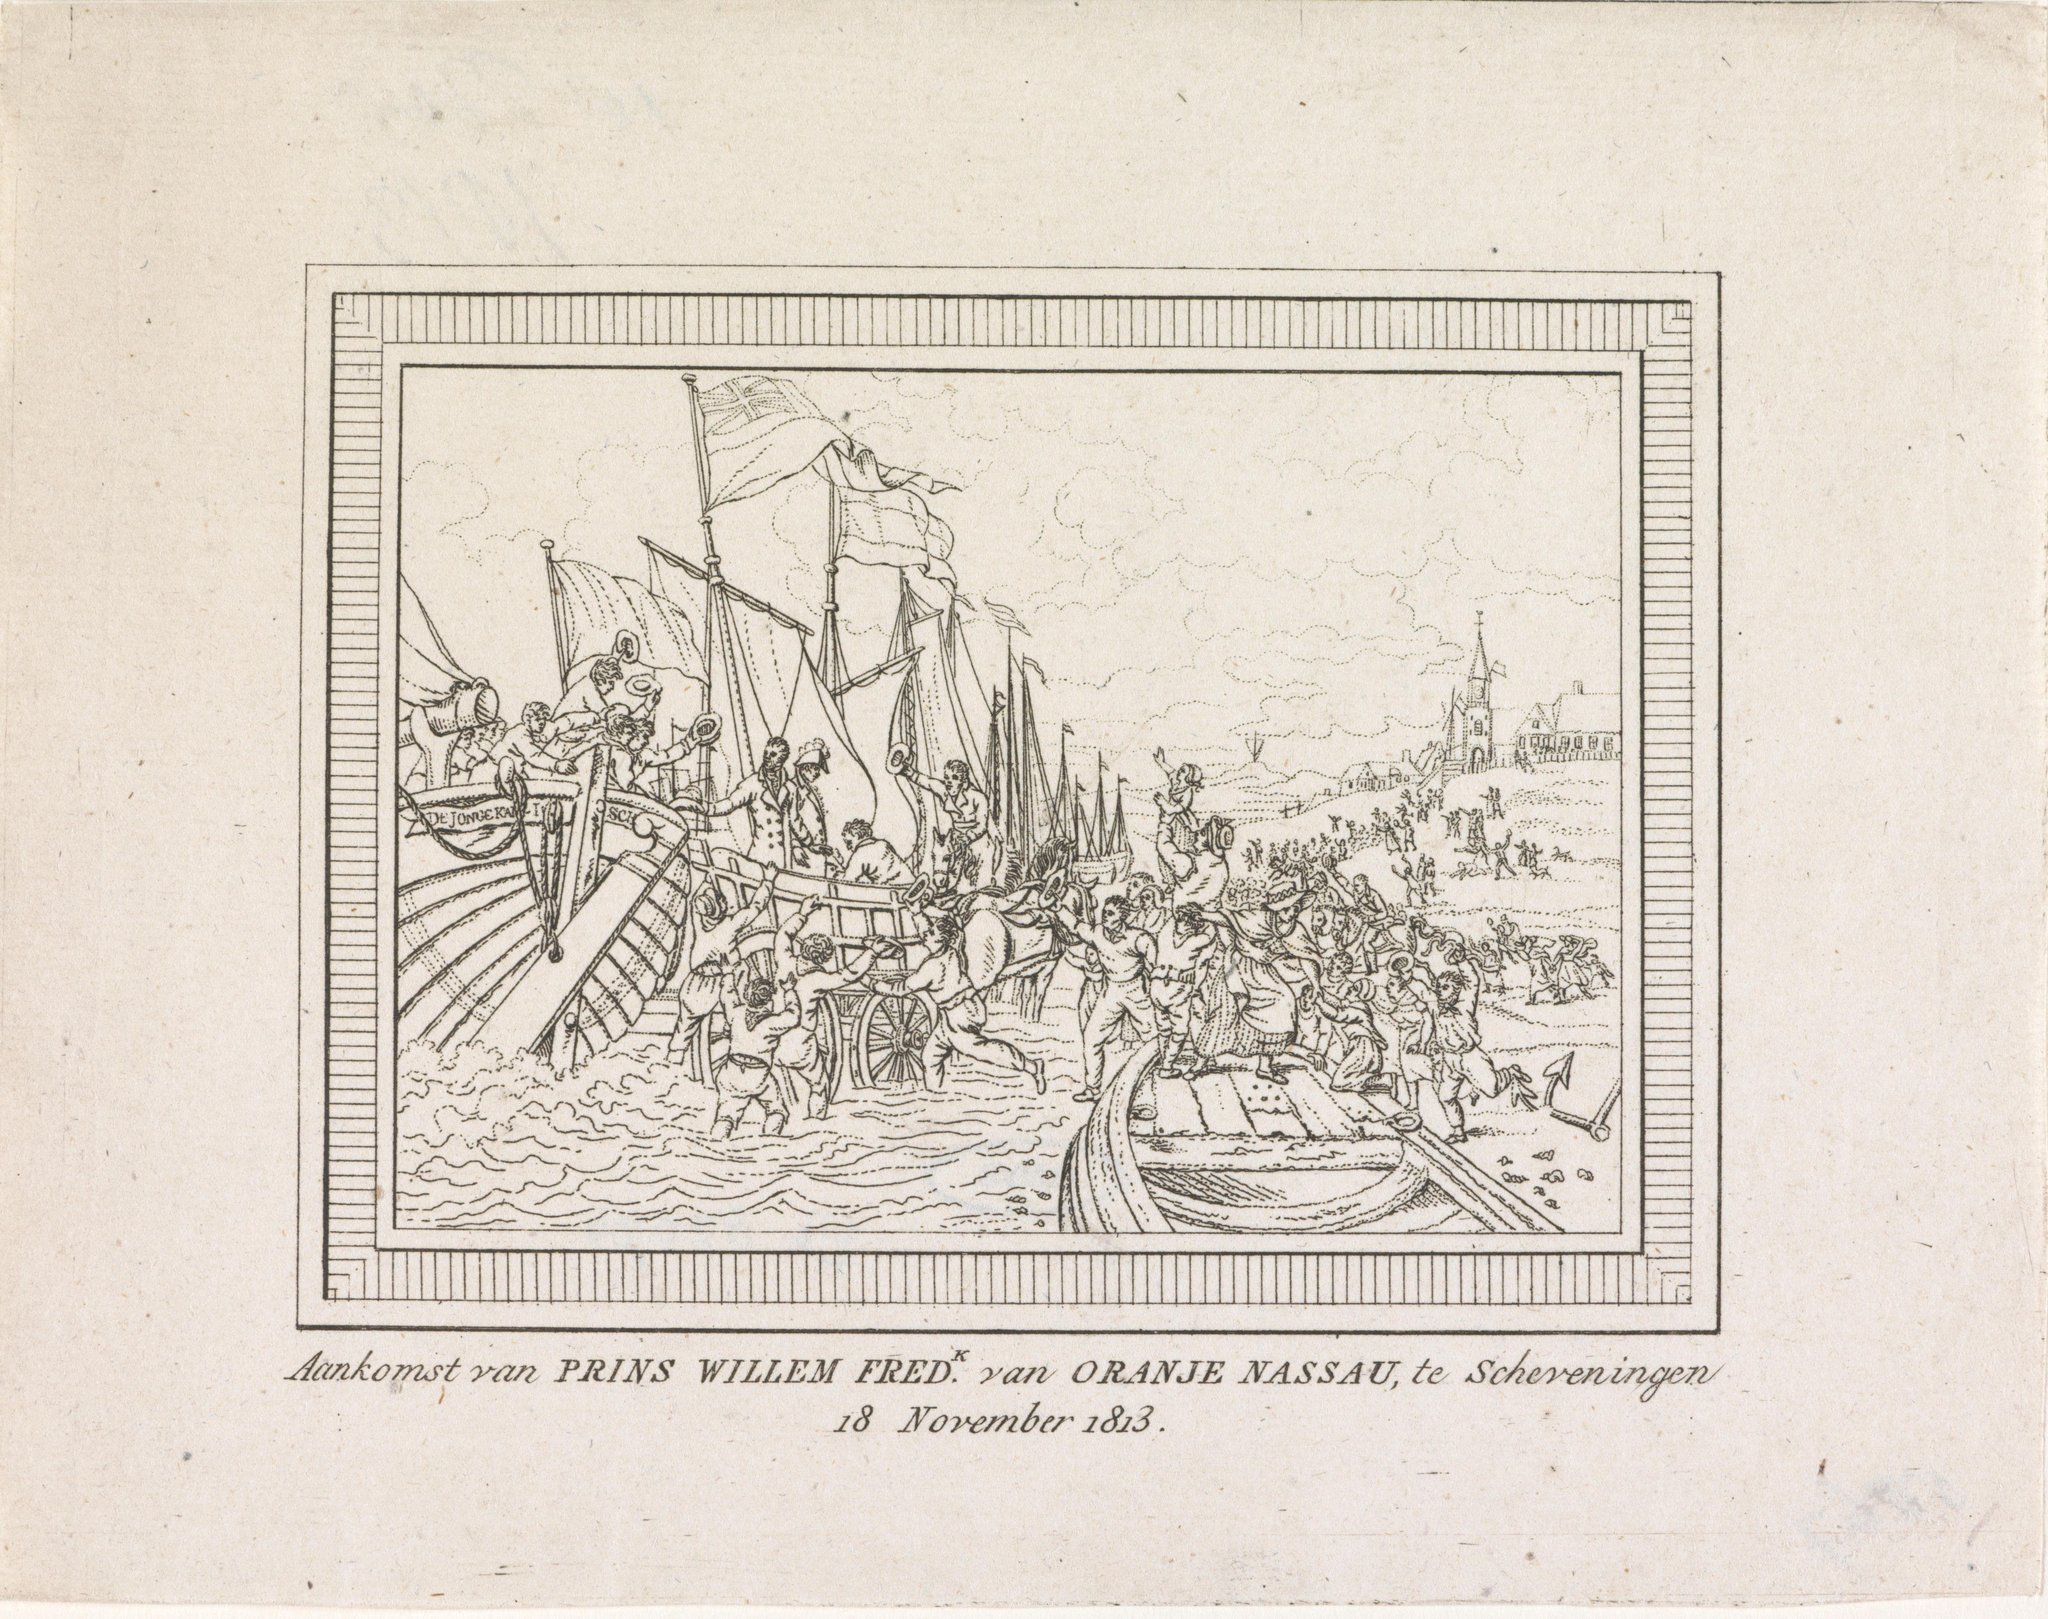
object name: print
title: Aankomst van de prins van Oranje te Scheveningen, 1813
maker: Anonymous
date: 1813-1815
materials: paper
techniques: etching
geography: netherlands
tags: the hague, berlin, william i of the netherlands, being welcomed ~ travelling, homage to a ruler, landing of william frederick i (1813)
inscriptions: collector's mark: Lugt 2228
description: De aankomst van prins Willem Frederik als souverein vorst op het strand van Scheveningen op 30 november 1813. Voorstelling in contouren binnen omlijsting.